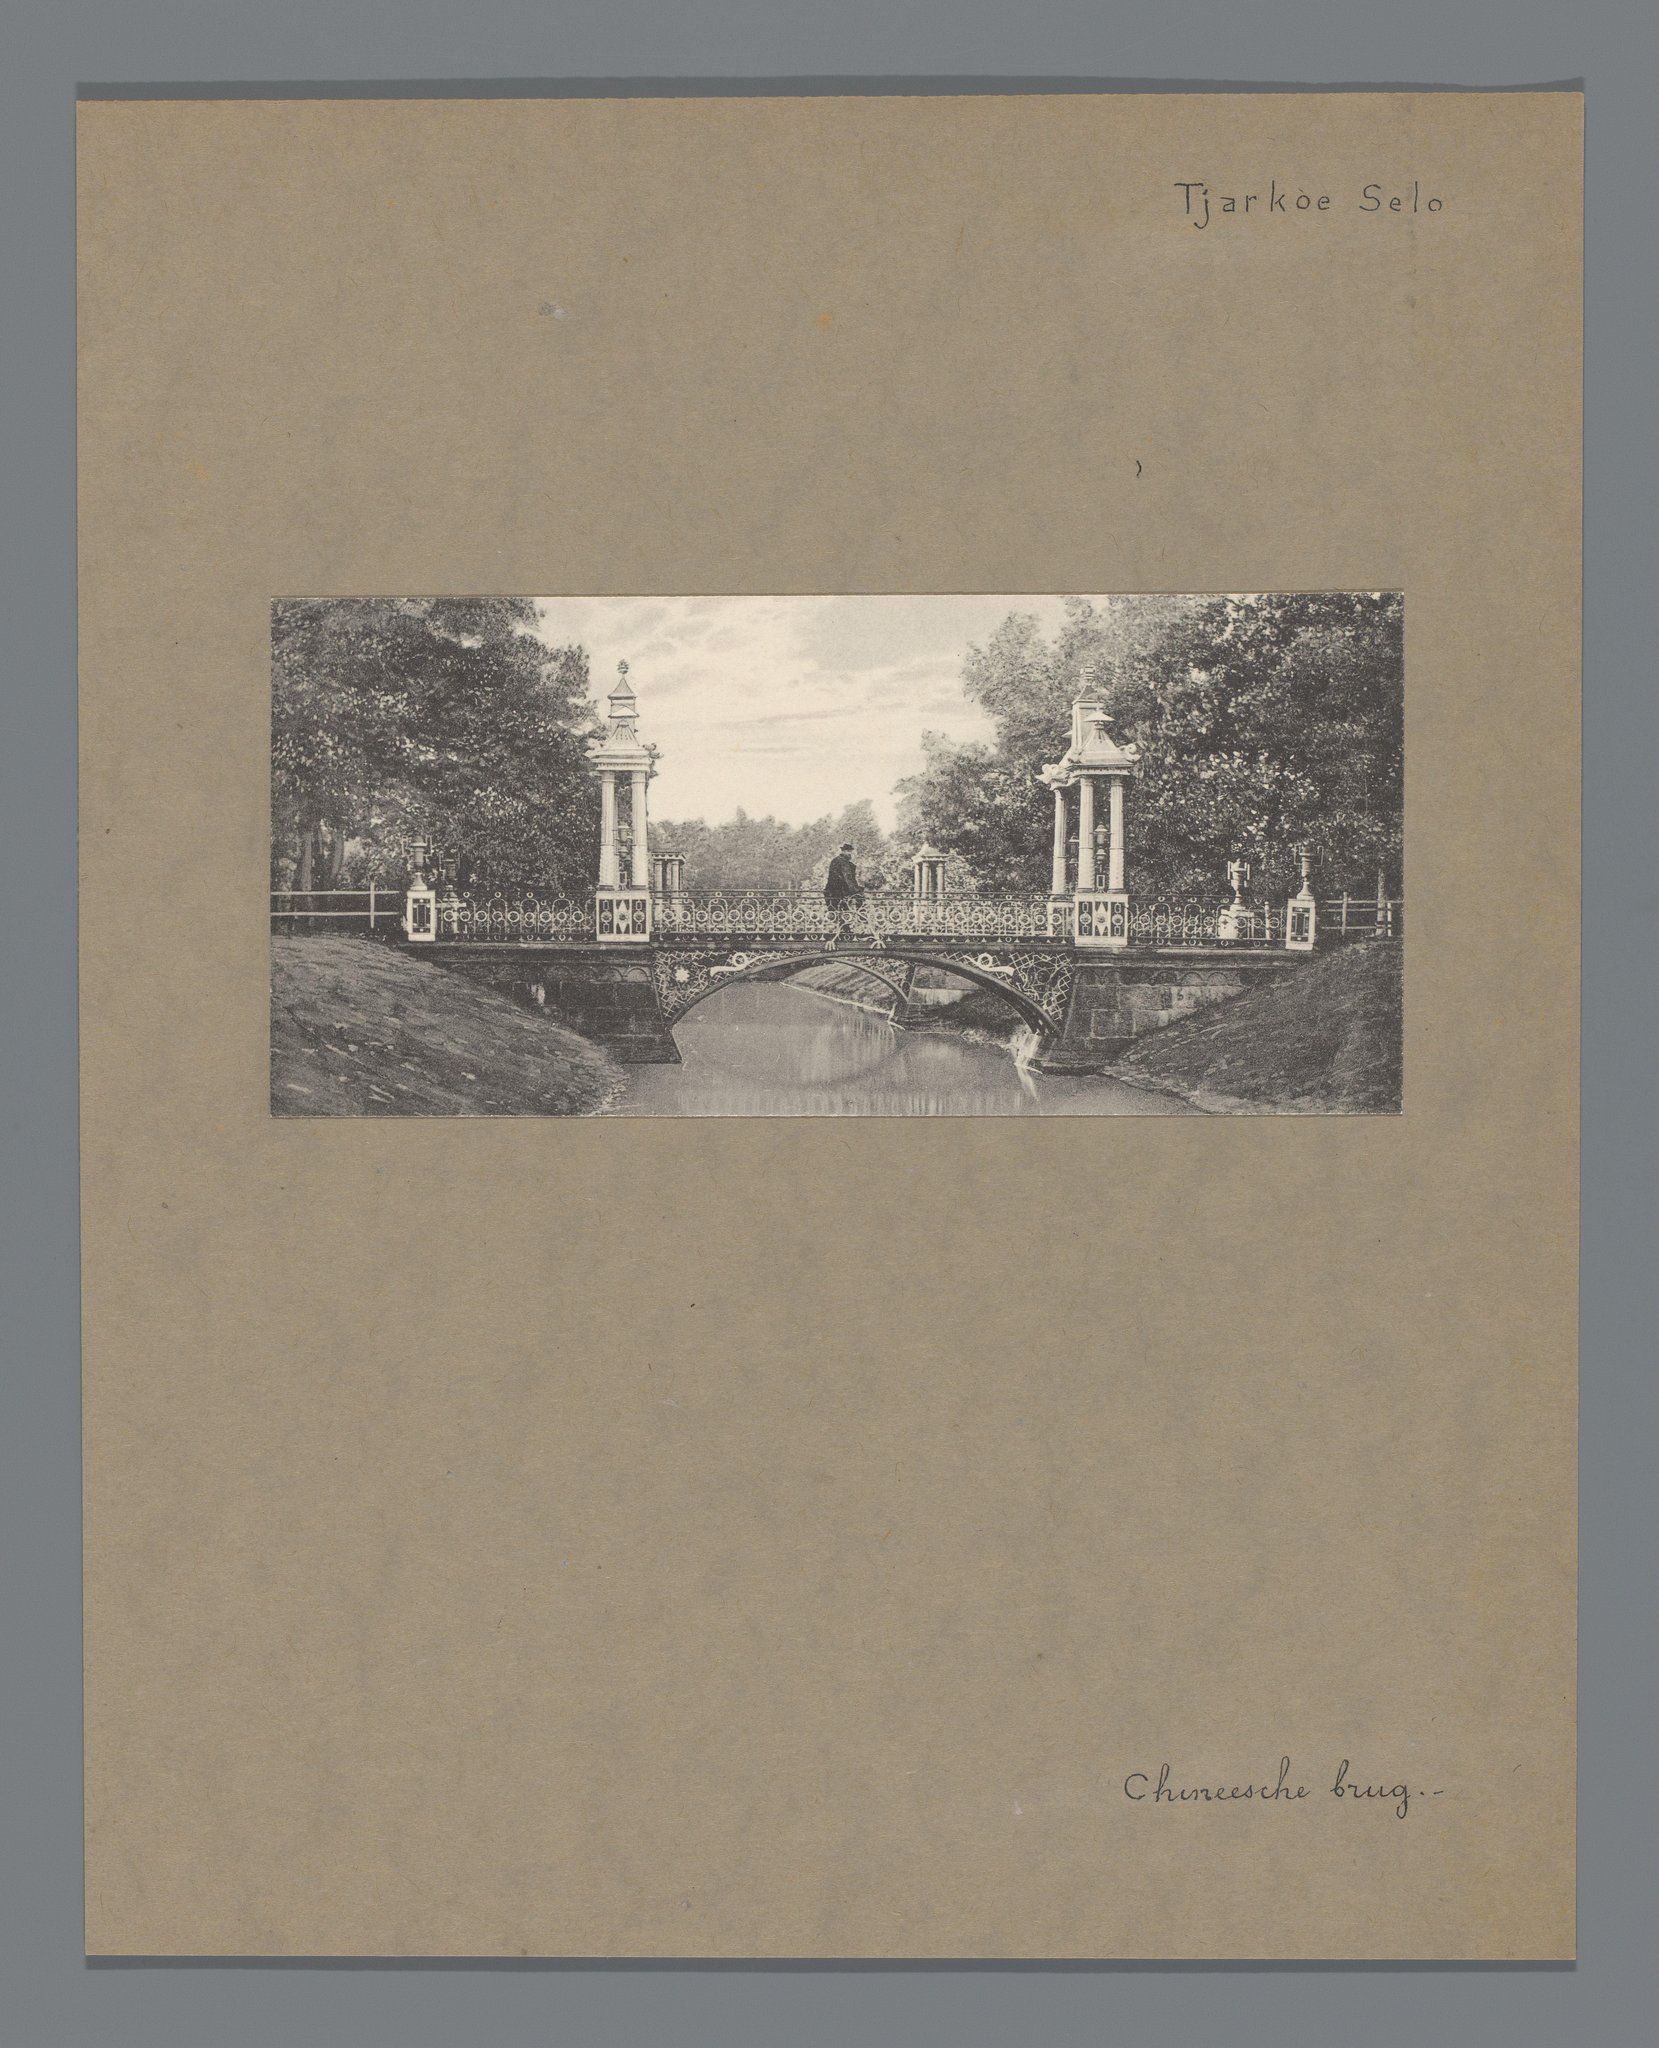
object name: photograph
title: Chineesche brug. Tjarkoe Selo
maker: Anonymous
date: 1860-1925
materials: photographic support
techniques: photograph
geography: russia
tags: russia